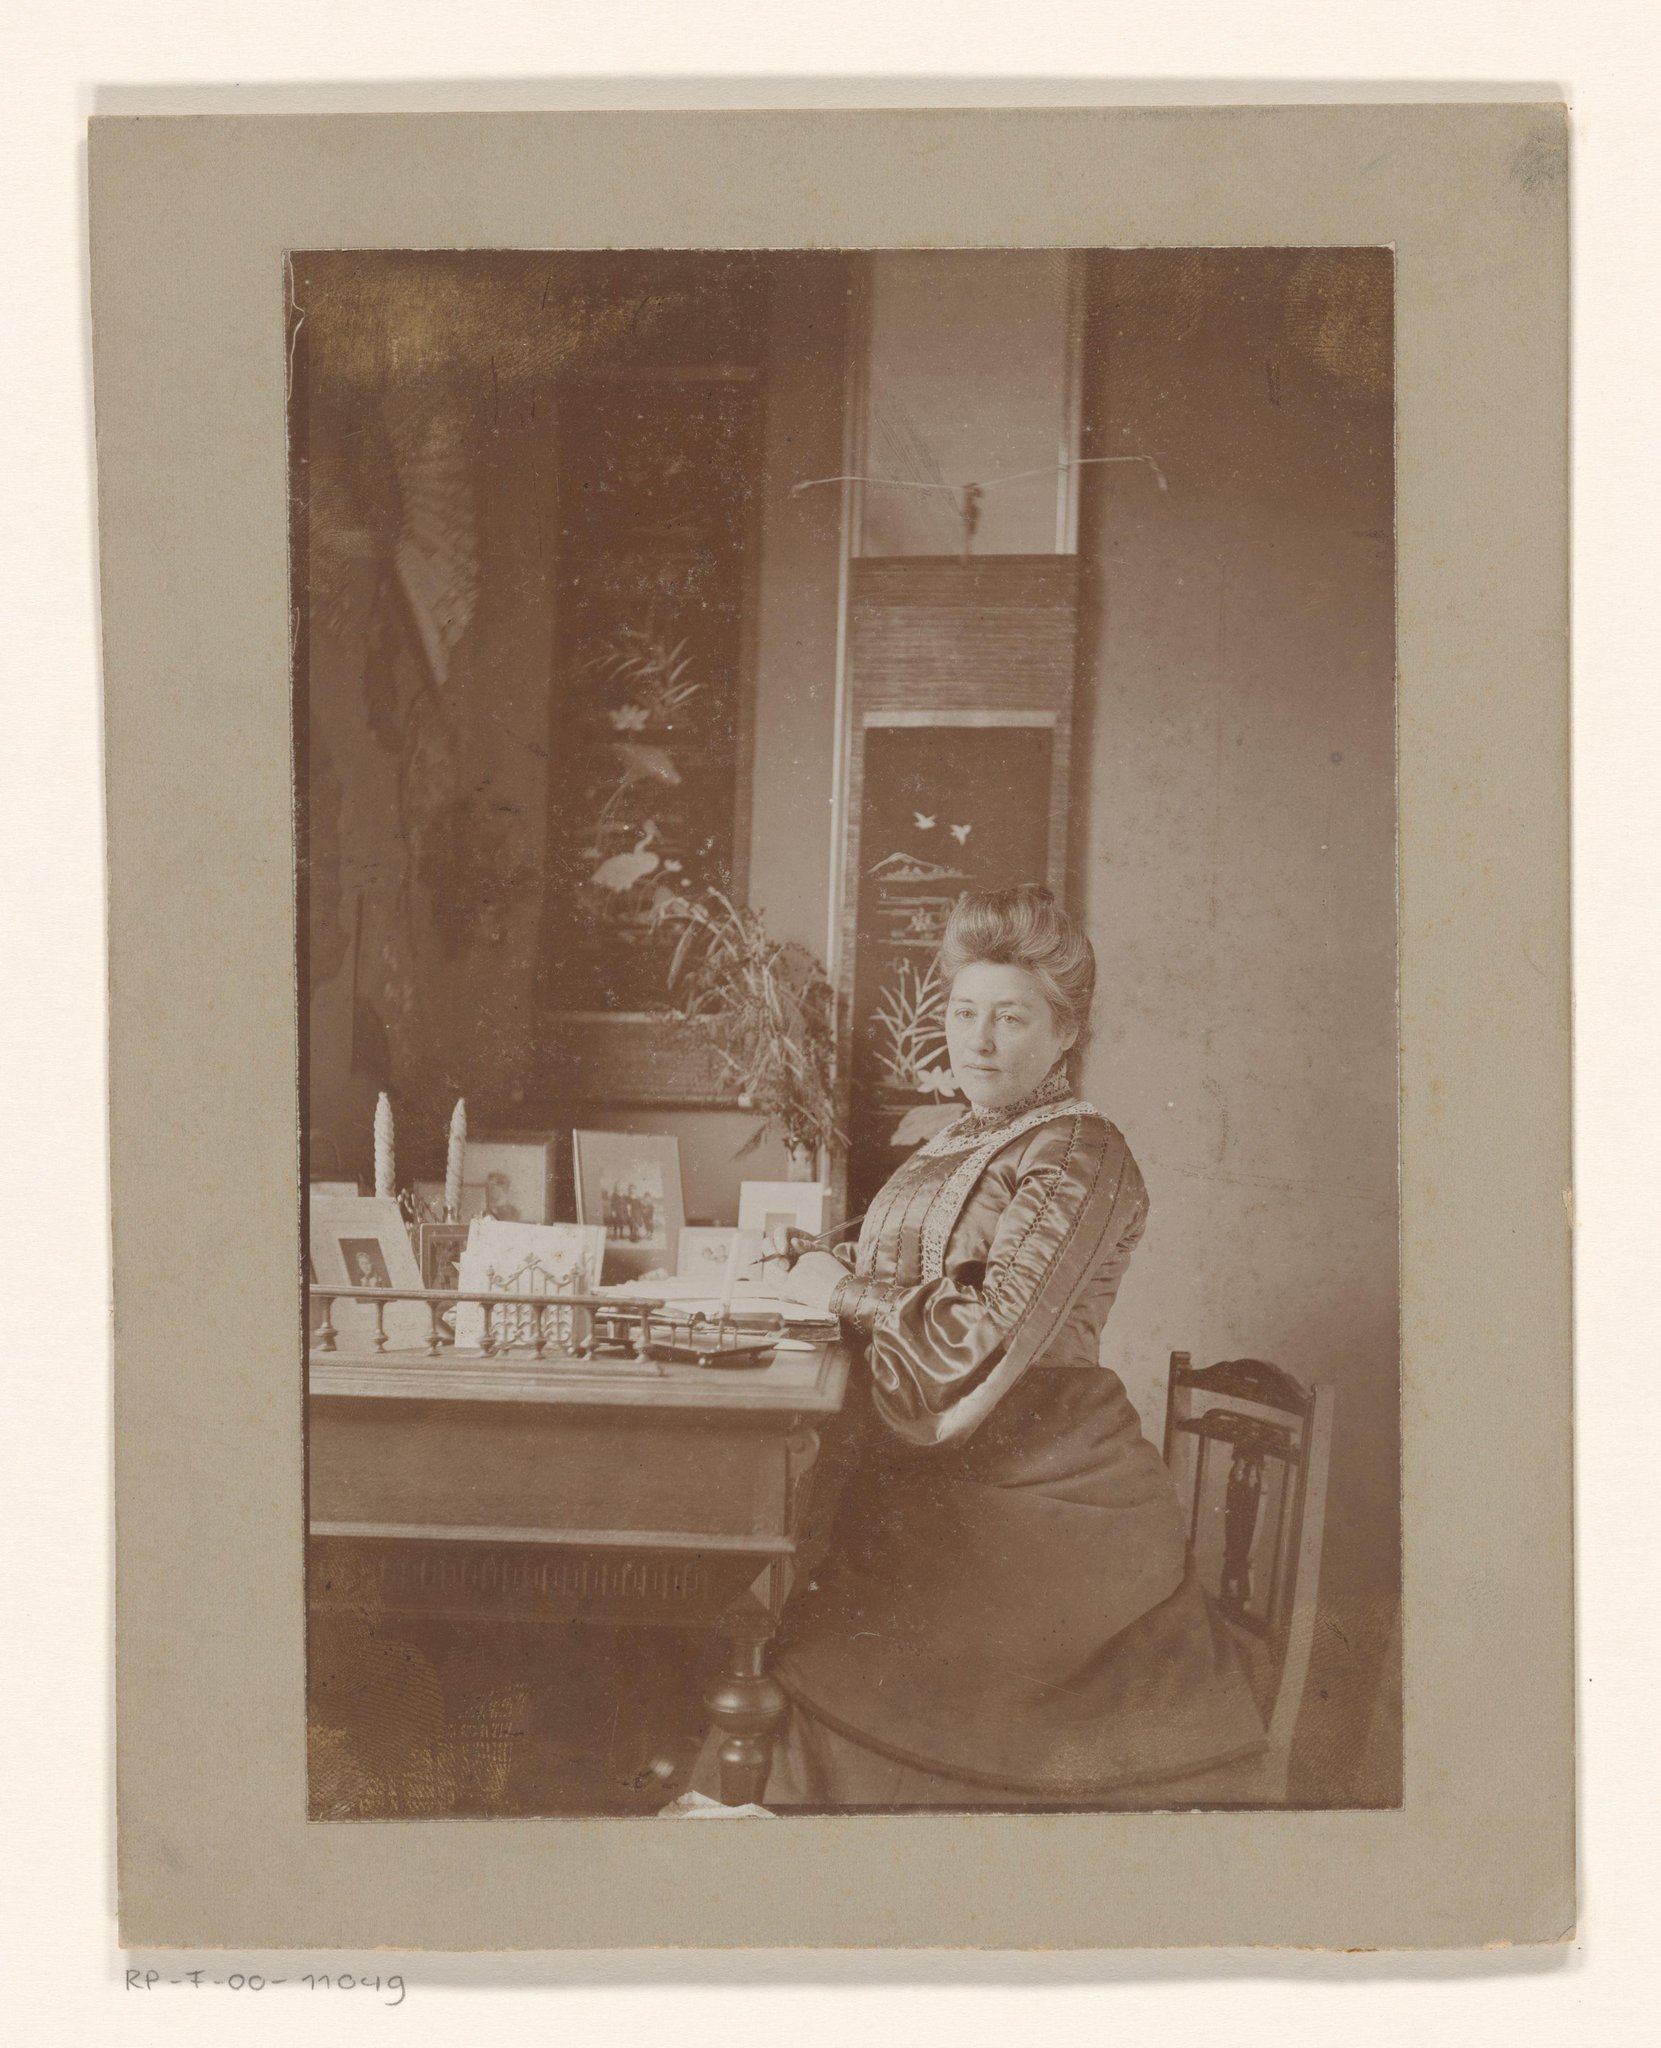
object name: photograph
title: Portret van een vrouw aan een schrijftafel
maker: Anonymous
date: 1880-1930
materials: cardboard, photographic support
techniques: collodion silver print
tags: historical persons not known by name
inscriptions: :, collector's mark: Lugt 2228a